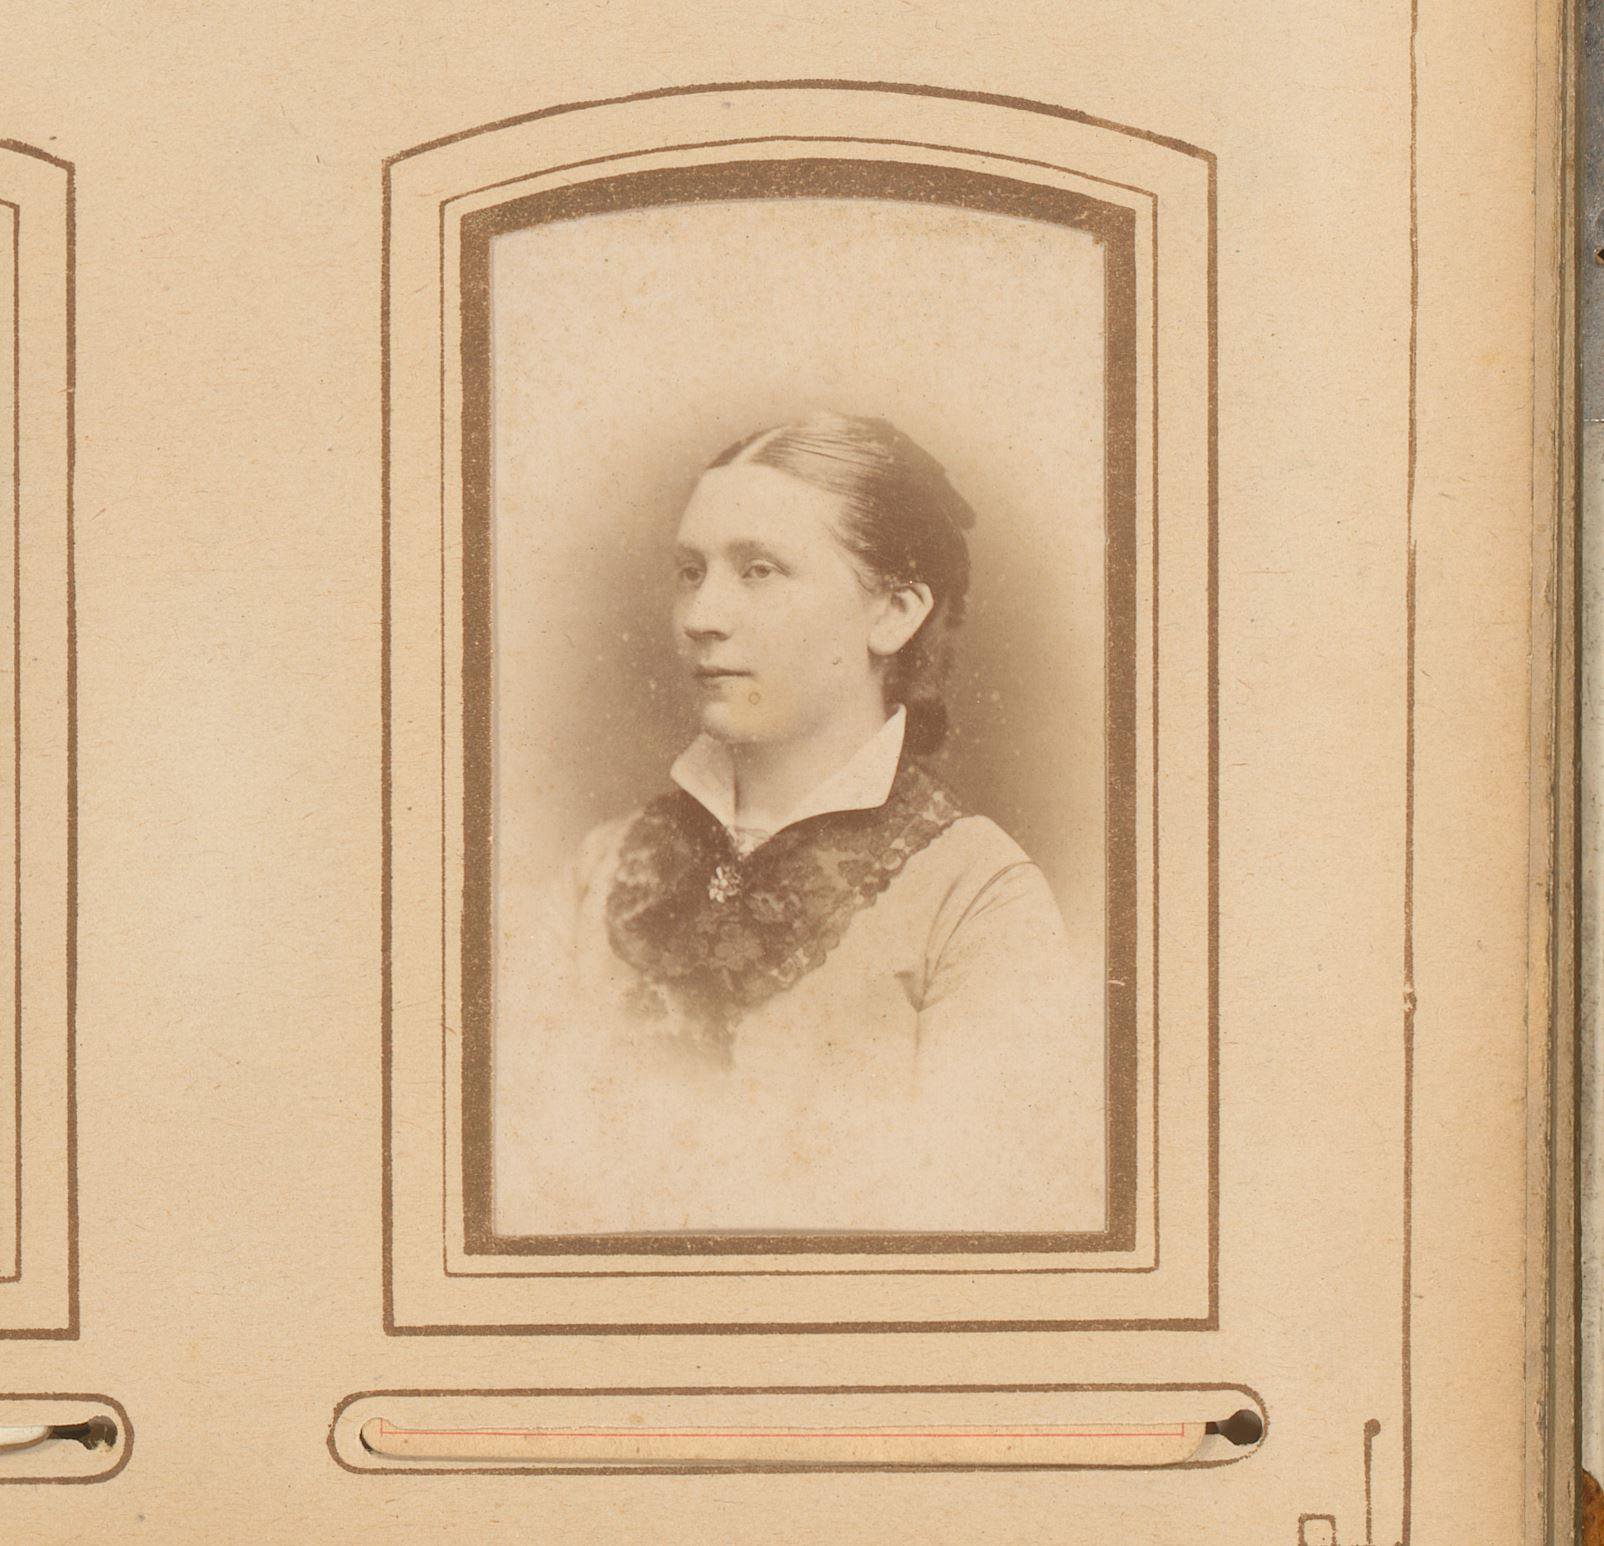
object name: album leaf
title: Portret van een jonge vrouw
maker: abraham koorenhoff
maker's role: fotograaf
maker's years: 1844-1917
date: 1880-1920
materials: cardboard, photographic support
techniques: albumen print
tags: adolescent, young woman, maiden, historical persons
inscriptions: inscription: ‘A. Koorenhoff/ Photographe/ Leiden/ Gerecht No. 5/ bij de Pieterskerk (...)’